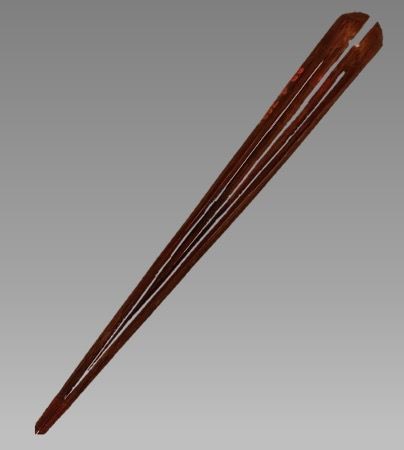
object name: darubiri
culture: melanesian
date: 1801-1900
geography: new guinea